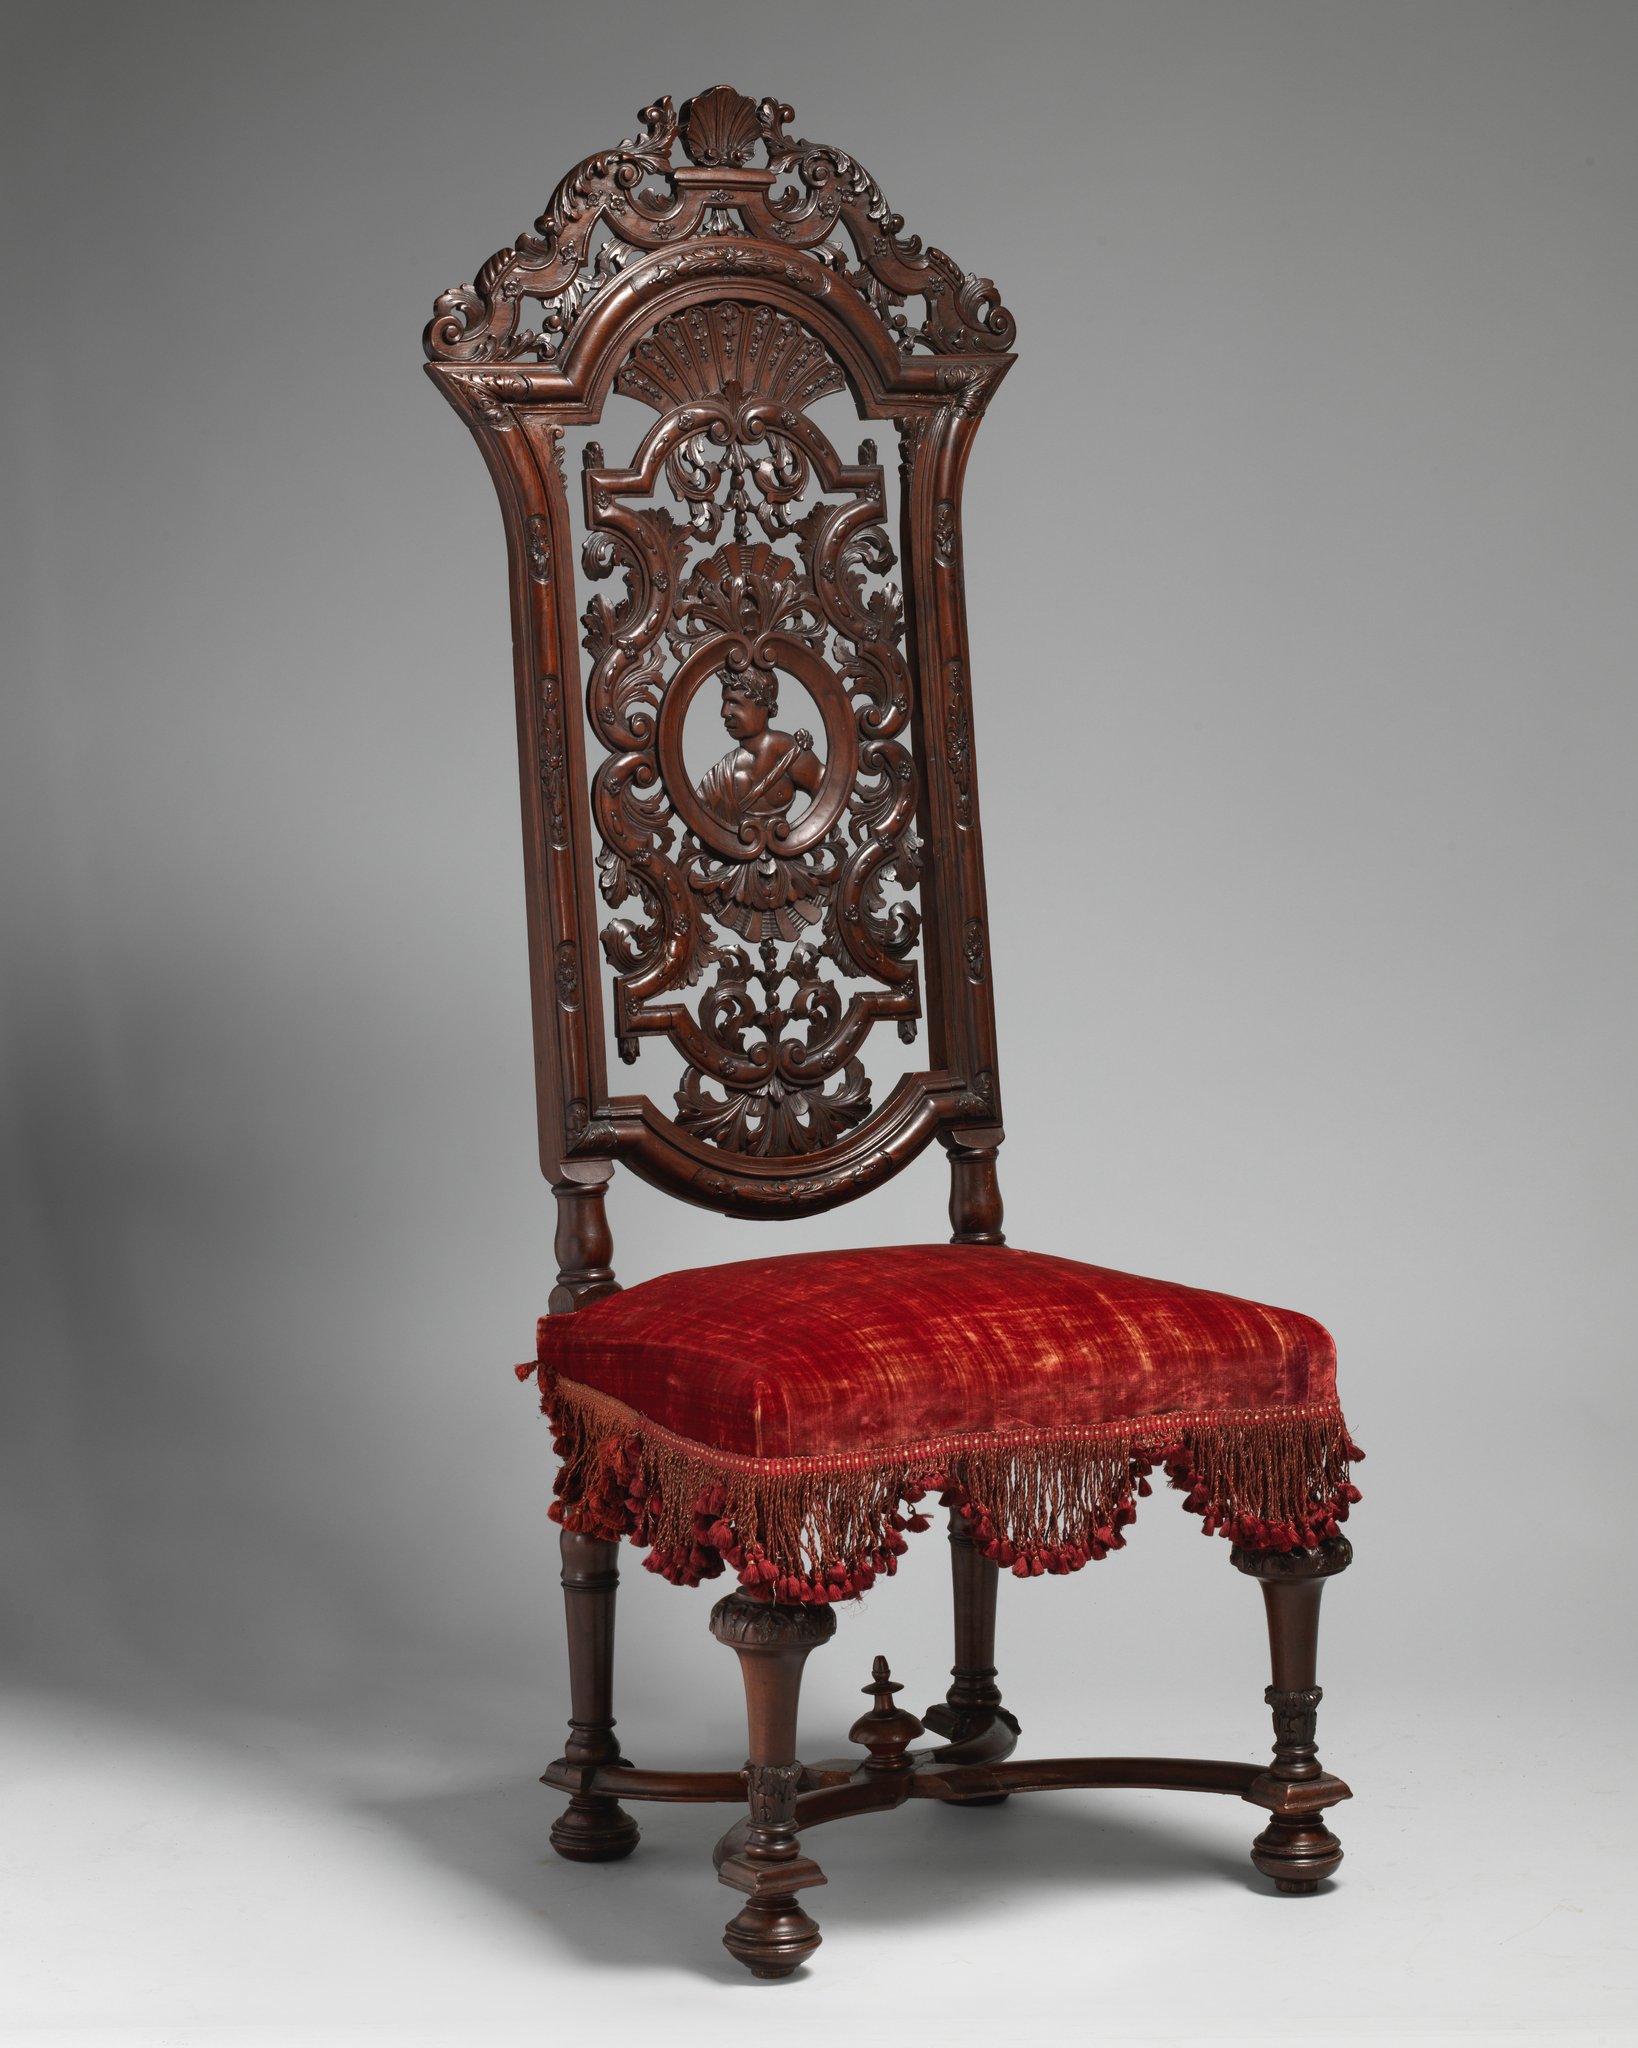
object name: chair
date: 1690-1695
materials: wood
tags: men,profiles